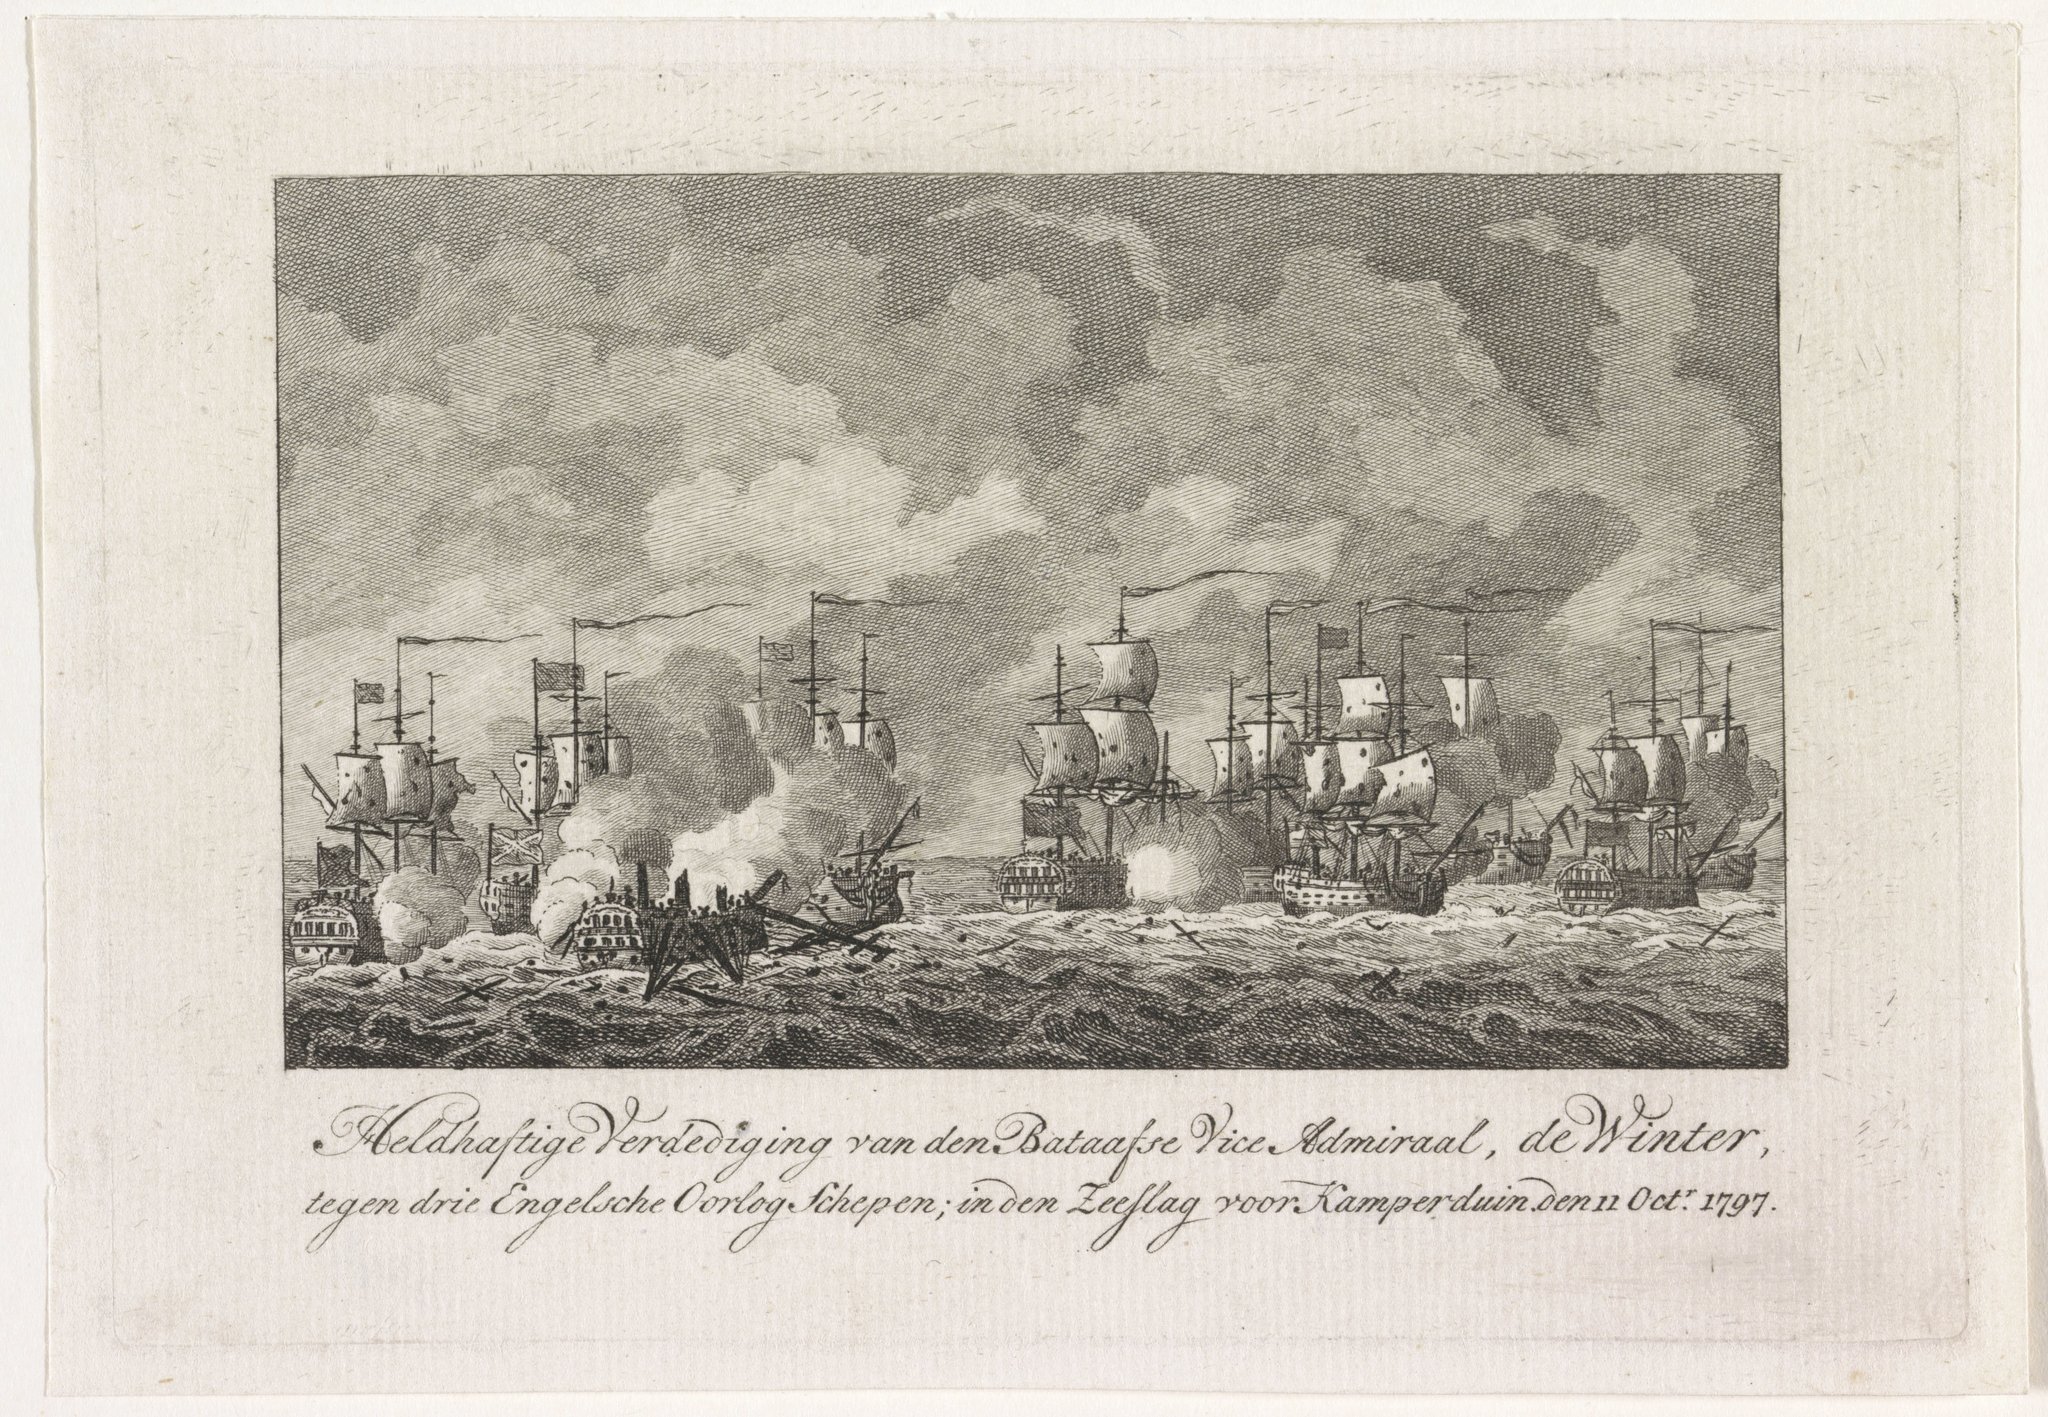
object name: print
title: Heldhaftige Verdediging van den Bataafse Vice Admiraal, de Winter, tegen drie Engelsche Oorlog Schepen; in den Zeeslag voor Kamperduin den 11 Octr. 1797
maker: Anonymous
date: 1797-1798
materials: paper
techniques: engraving, etching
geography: netherlands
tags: paris, jan willem de winter, battle (+ naval force), battle of camperdown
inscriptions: collector's mark: Lugt 2228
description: De Zeeslag bij Kamperduin op 11 oktober 1797 tussen de Bataafse vloot onder bevel van viceadmiraal Jan Willem de Winter en een Britse vloot onder admiraal Adam Duncan. Op de voorgrond het mastloze schip de Vrijheid van De Winter.